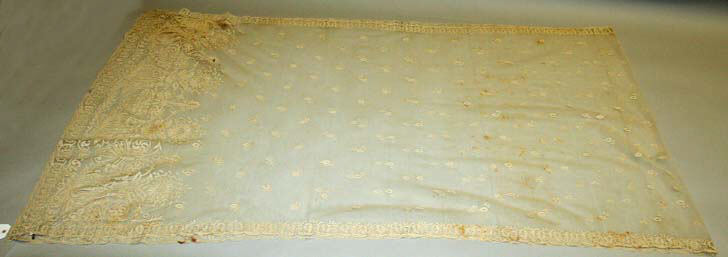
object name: scarf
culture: french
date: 1801-1825